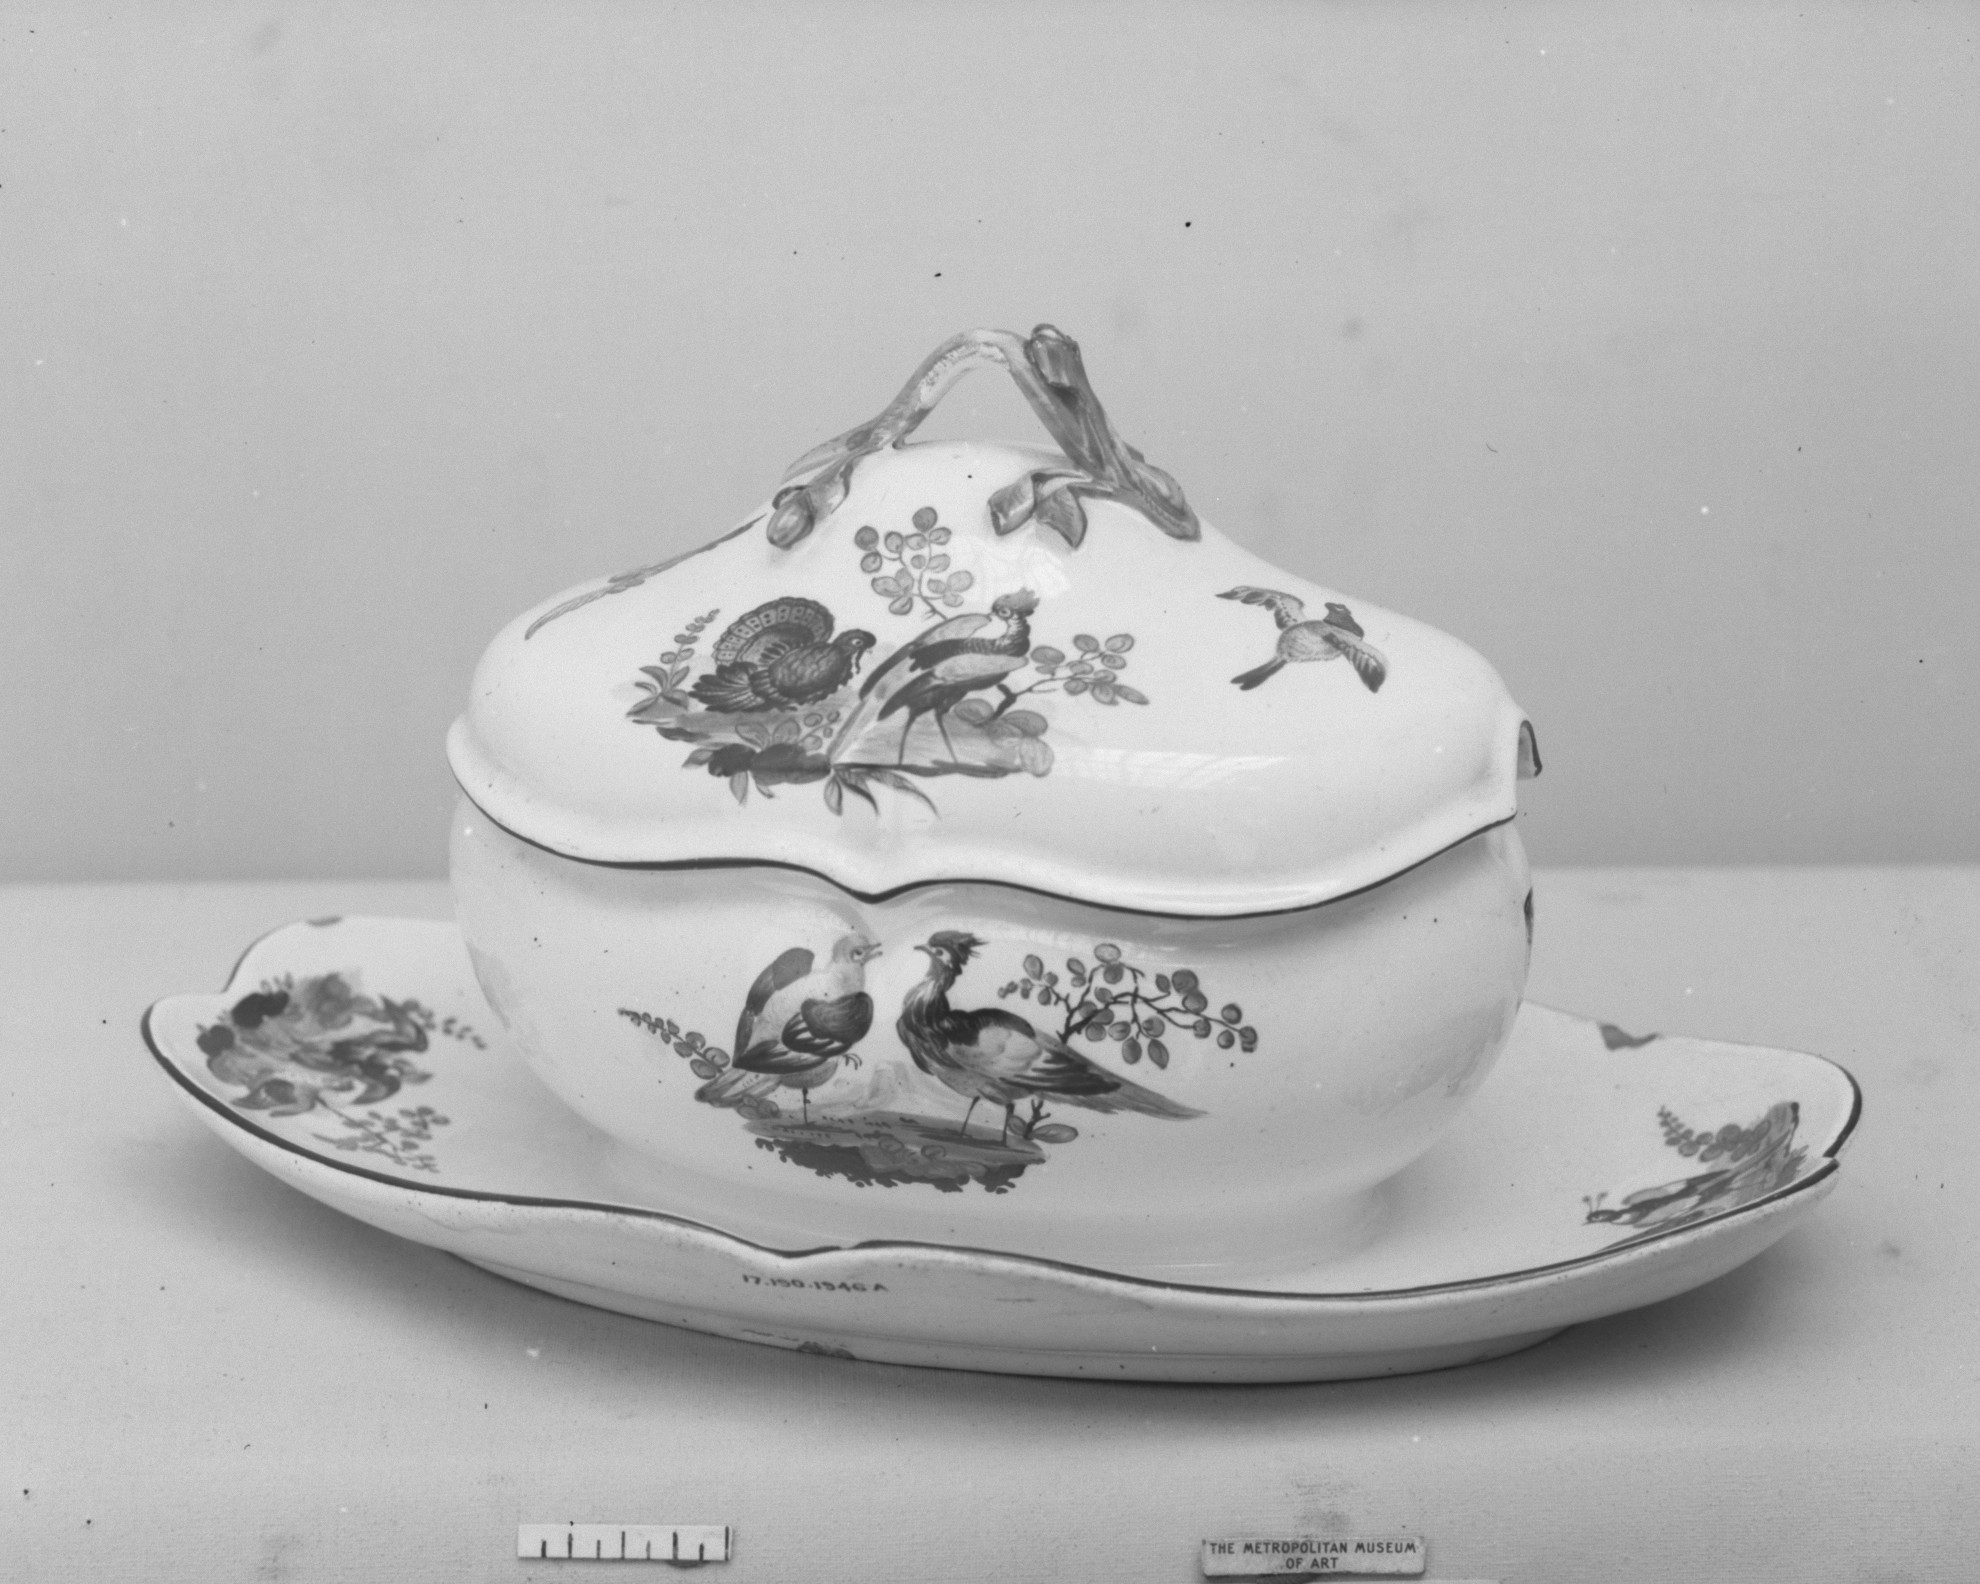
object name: sauce tureen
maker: levavasseur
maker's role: manufactory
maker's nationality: french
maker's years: 1715-1825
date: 1701-1800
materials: faience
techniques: glazing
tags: birds,turkeys